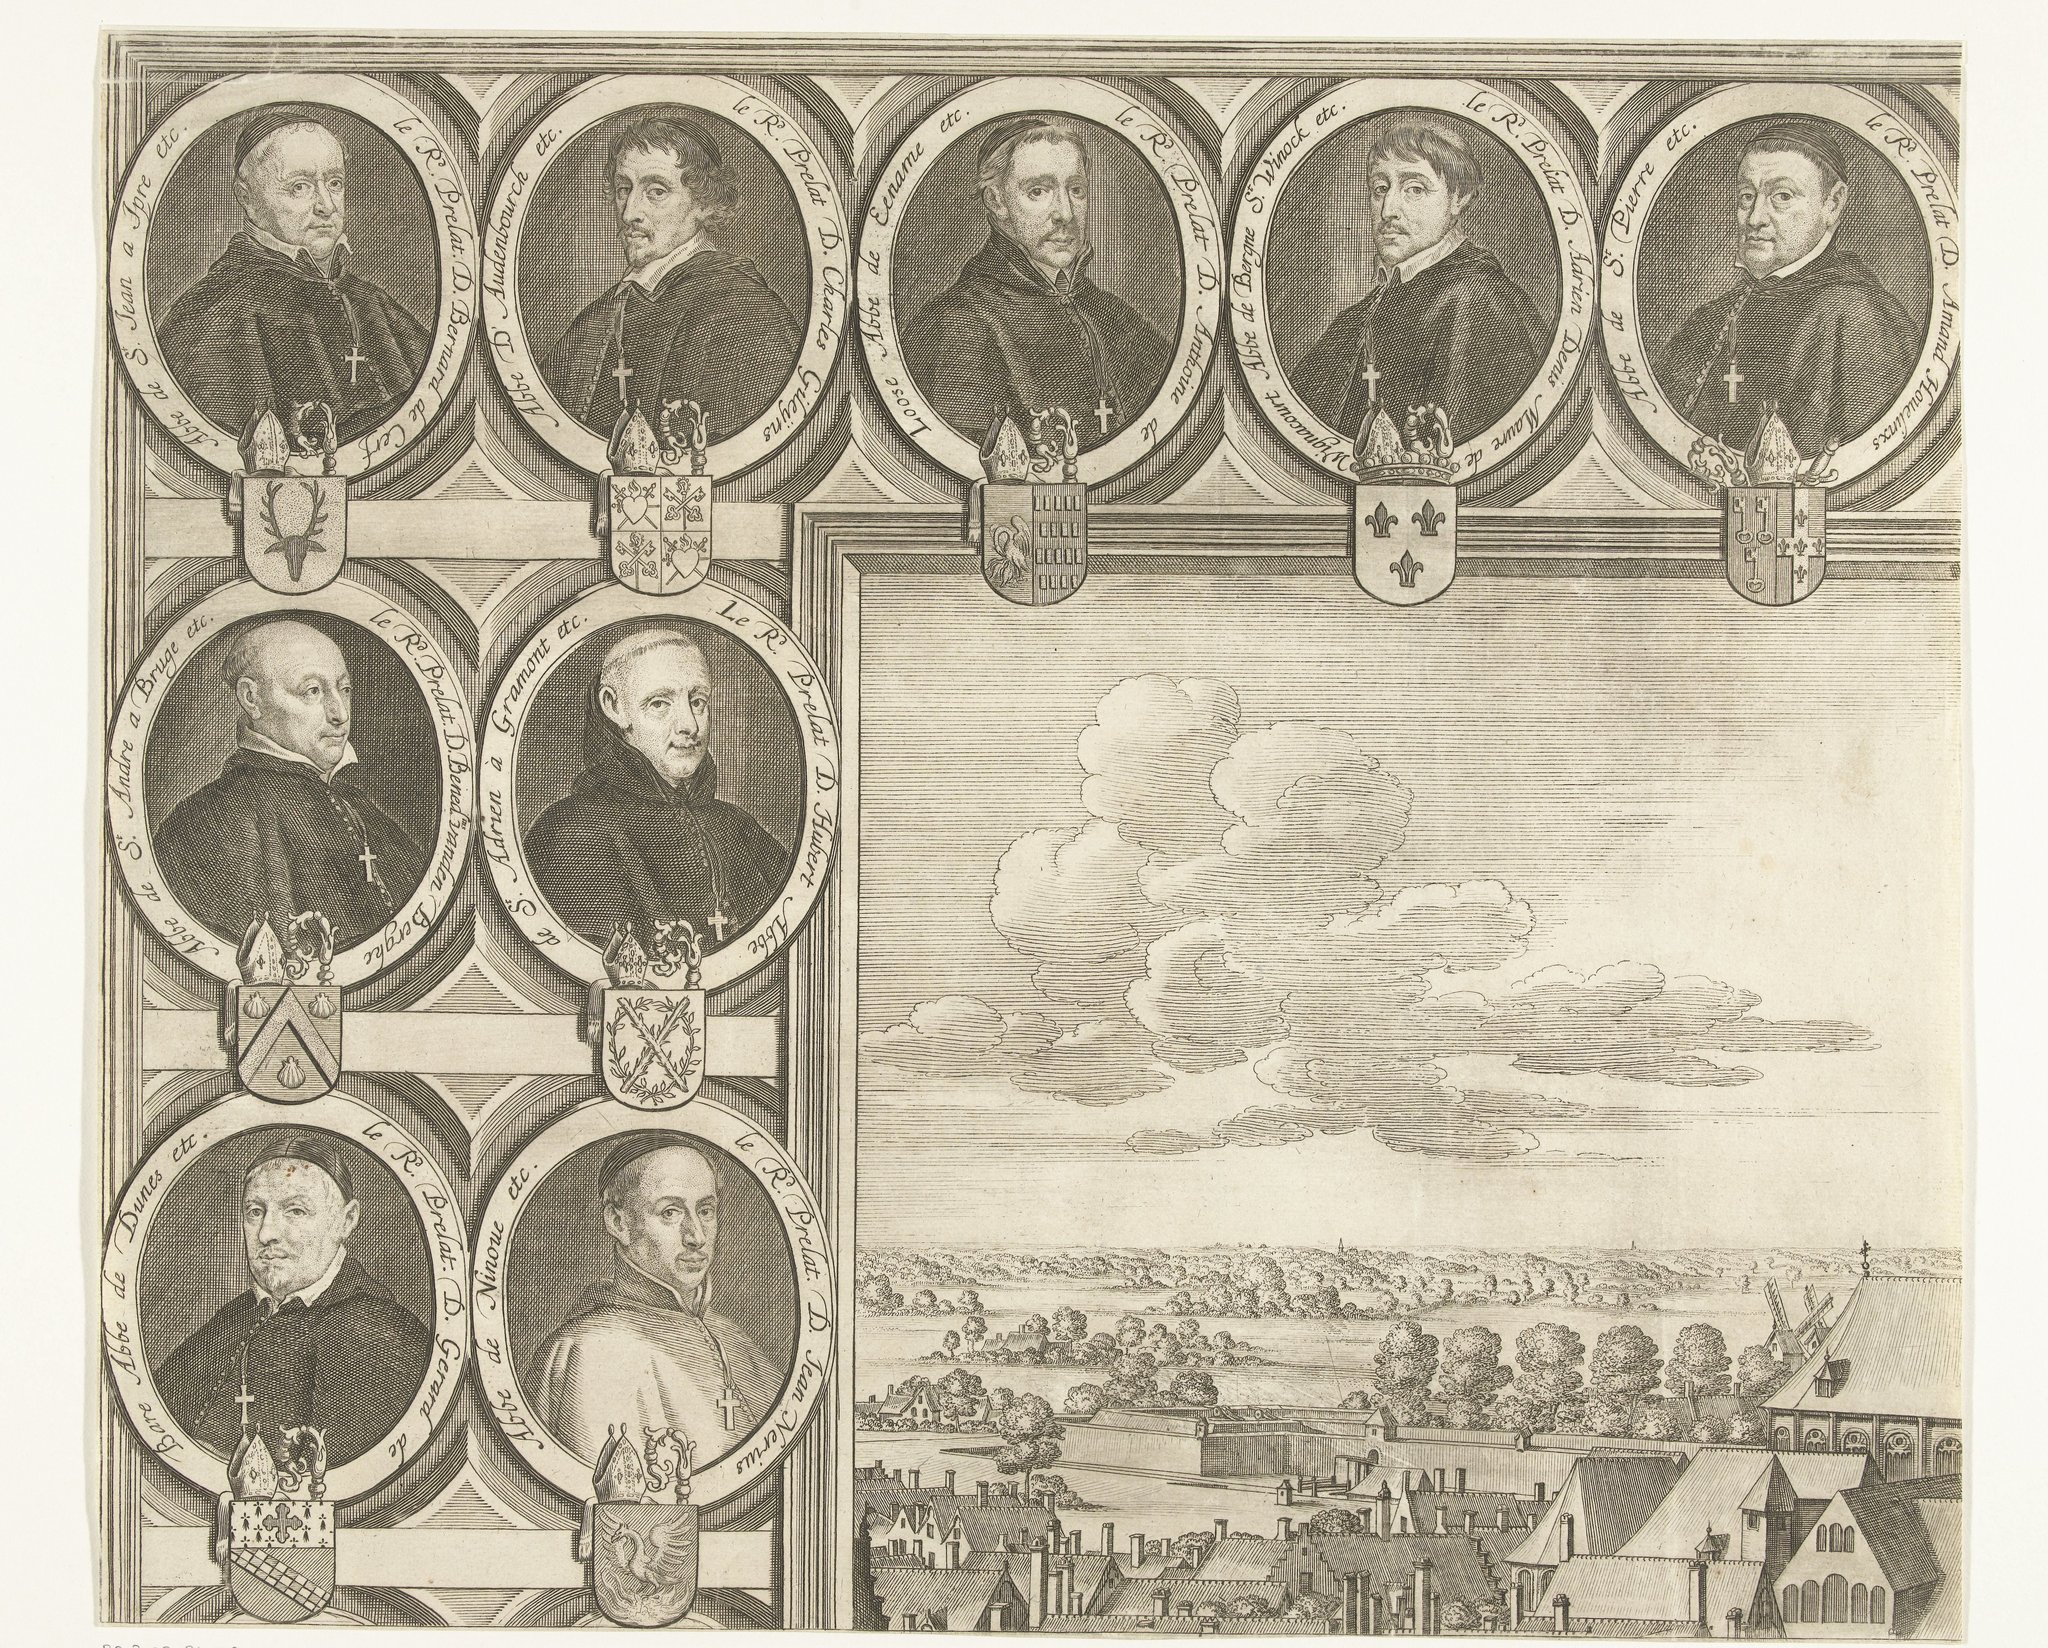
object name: print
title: Proclamatie te Gent van Karel II van Spanje als graaf van Vlaanderen (blad 1), 1666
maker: lucas vorsterman (ii)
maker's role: print maker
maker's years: 1624-1667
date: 1666-1667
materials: paper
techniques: engraving, etching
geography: southern netherlands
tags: karel ii (koning van spanje), ceremonial procession, parade, pageant ~ installation of a ruler, festivities (+ parade, pageant, cavalcade ~ festive activities)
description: Ceremonie op de Vrijdagmarkt te Gent bij de proclamatie van de Spaanse koning Karel II als graaf van Vlaanderen, 2 mei 1666. Blad 1 in een ongemonteerde ensemble van 12 platen van de ceremonie en cavalcade op het plein en 118 portretten van de hoogwaardigheidsbekleders die bij de plechtigheid aanwezig waren.